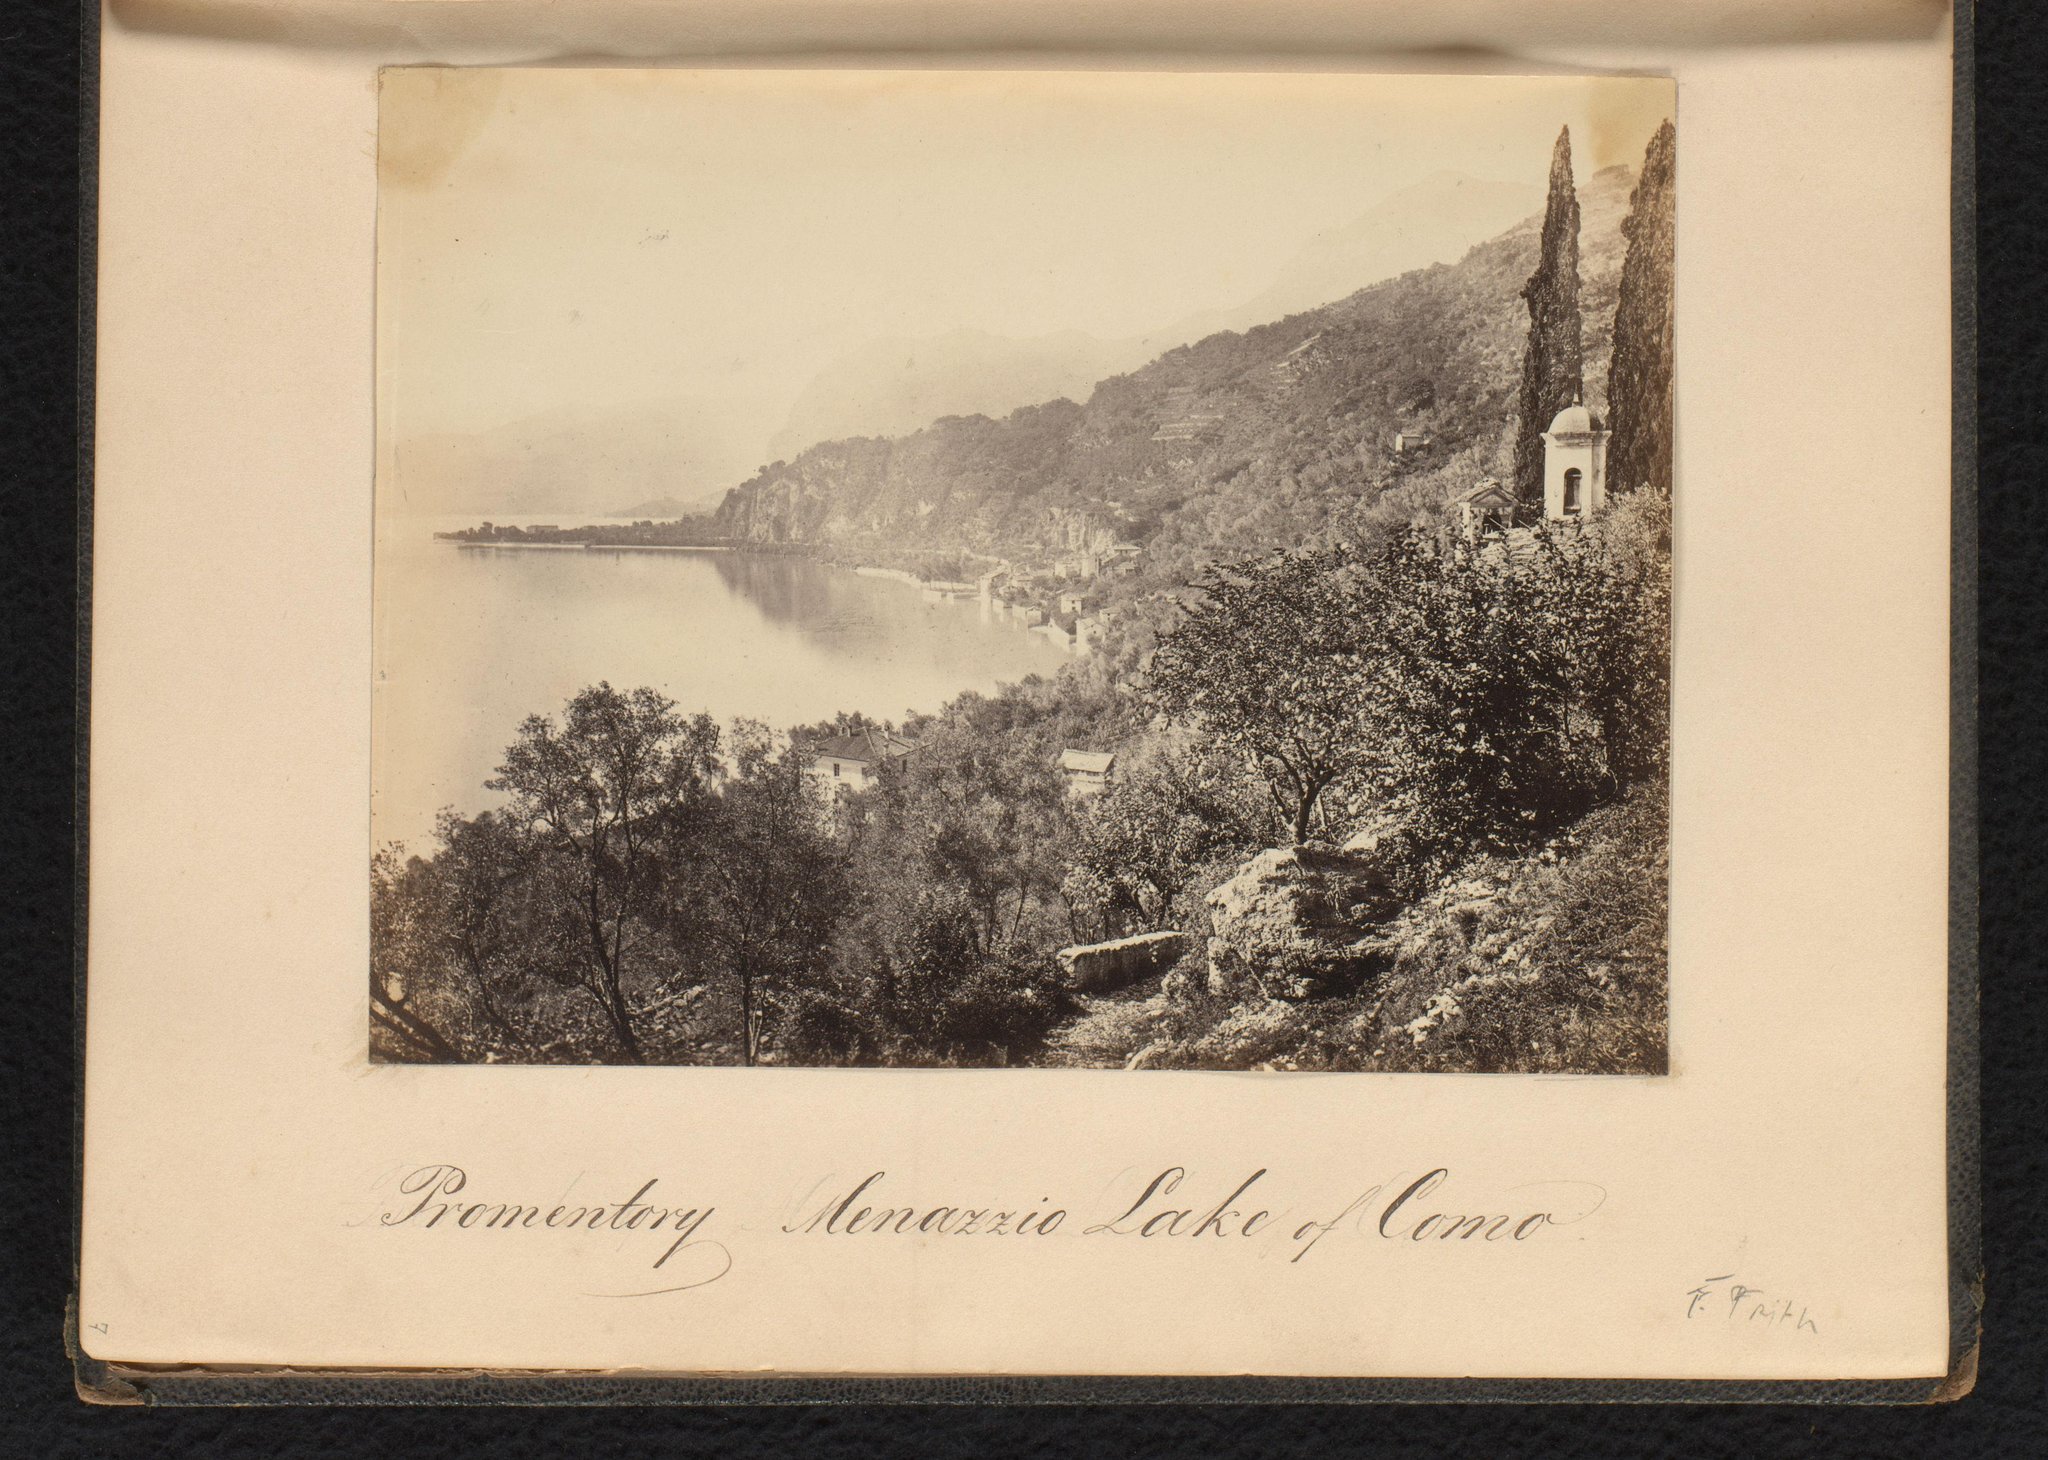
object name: album leaf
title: Gezicht op Menaggio en het Comomeer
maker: francis frith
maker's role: publisher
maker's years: 1822-1898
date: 1860-1870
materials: paper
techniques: albumen print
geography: menaggio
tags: lake